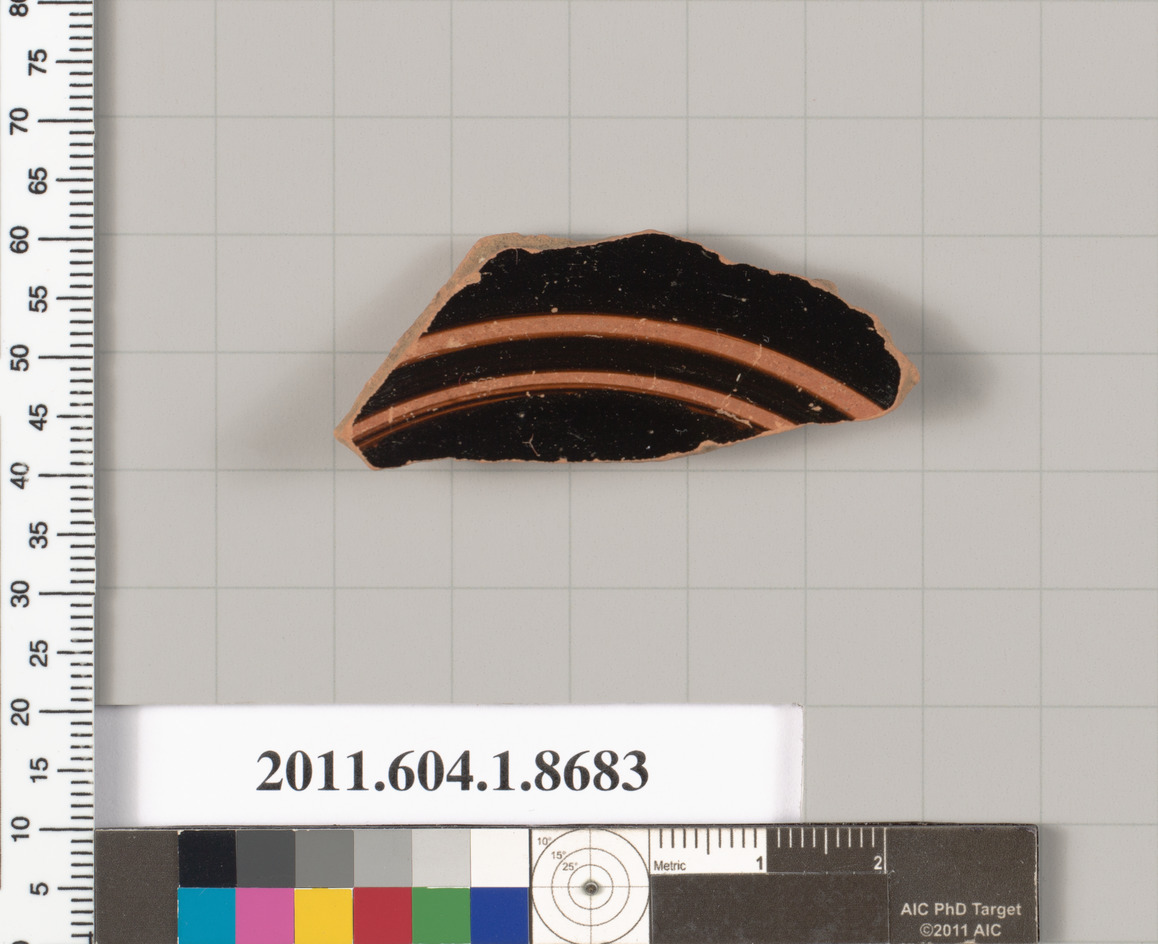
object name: kylix fragment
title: Terracotta fragment of a stemless kylix (drinking cup)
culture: greek, attic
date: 470-450 BCE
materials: terracotta